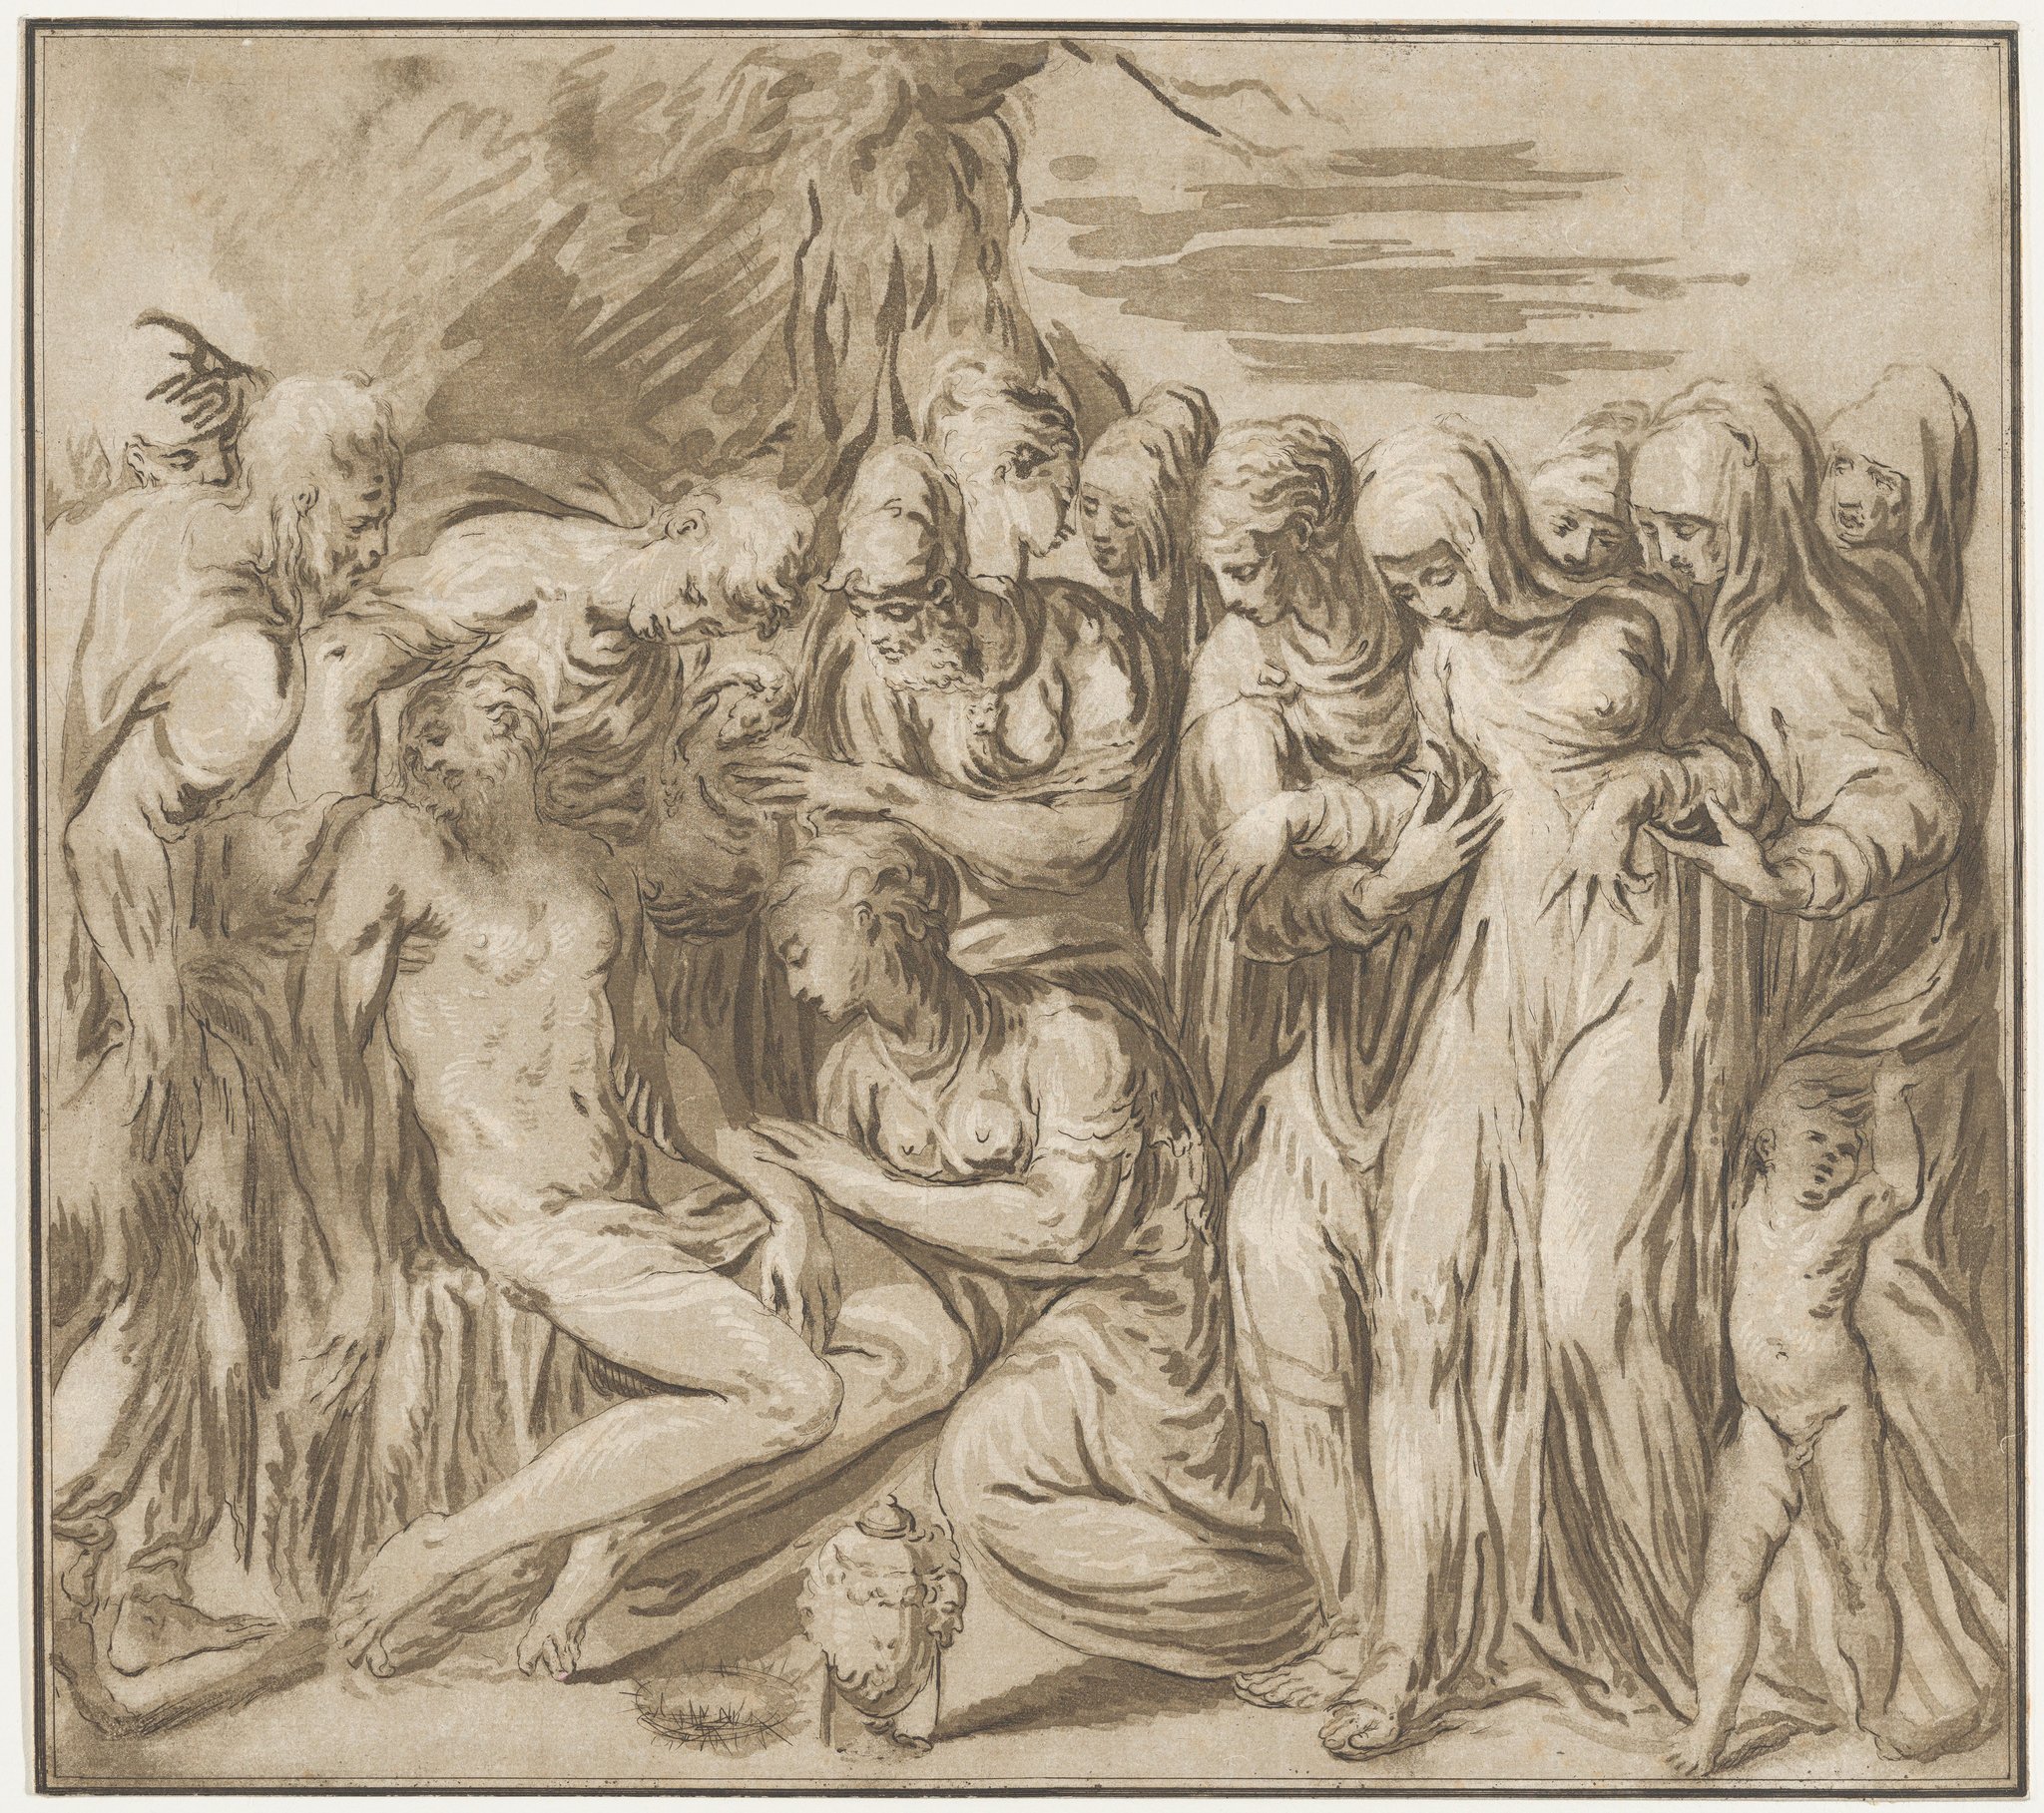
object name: print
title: The Annointing of Christ's Body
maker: adam von bartsch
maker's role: artist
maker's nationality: austrian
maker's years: 1757-1821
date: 1784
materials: ink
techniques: aquatint, etching